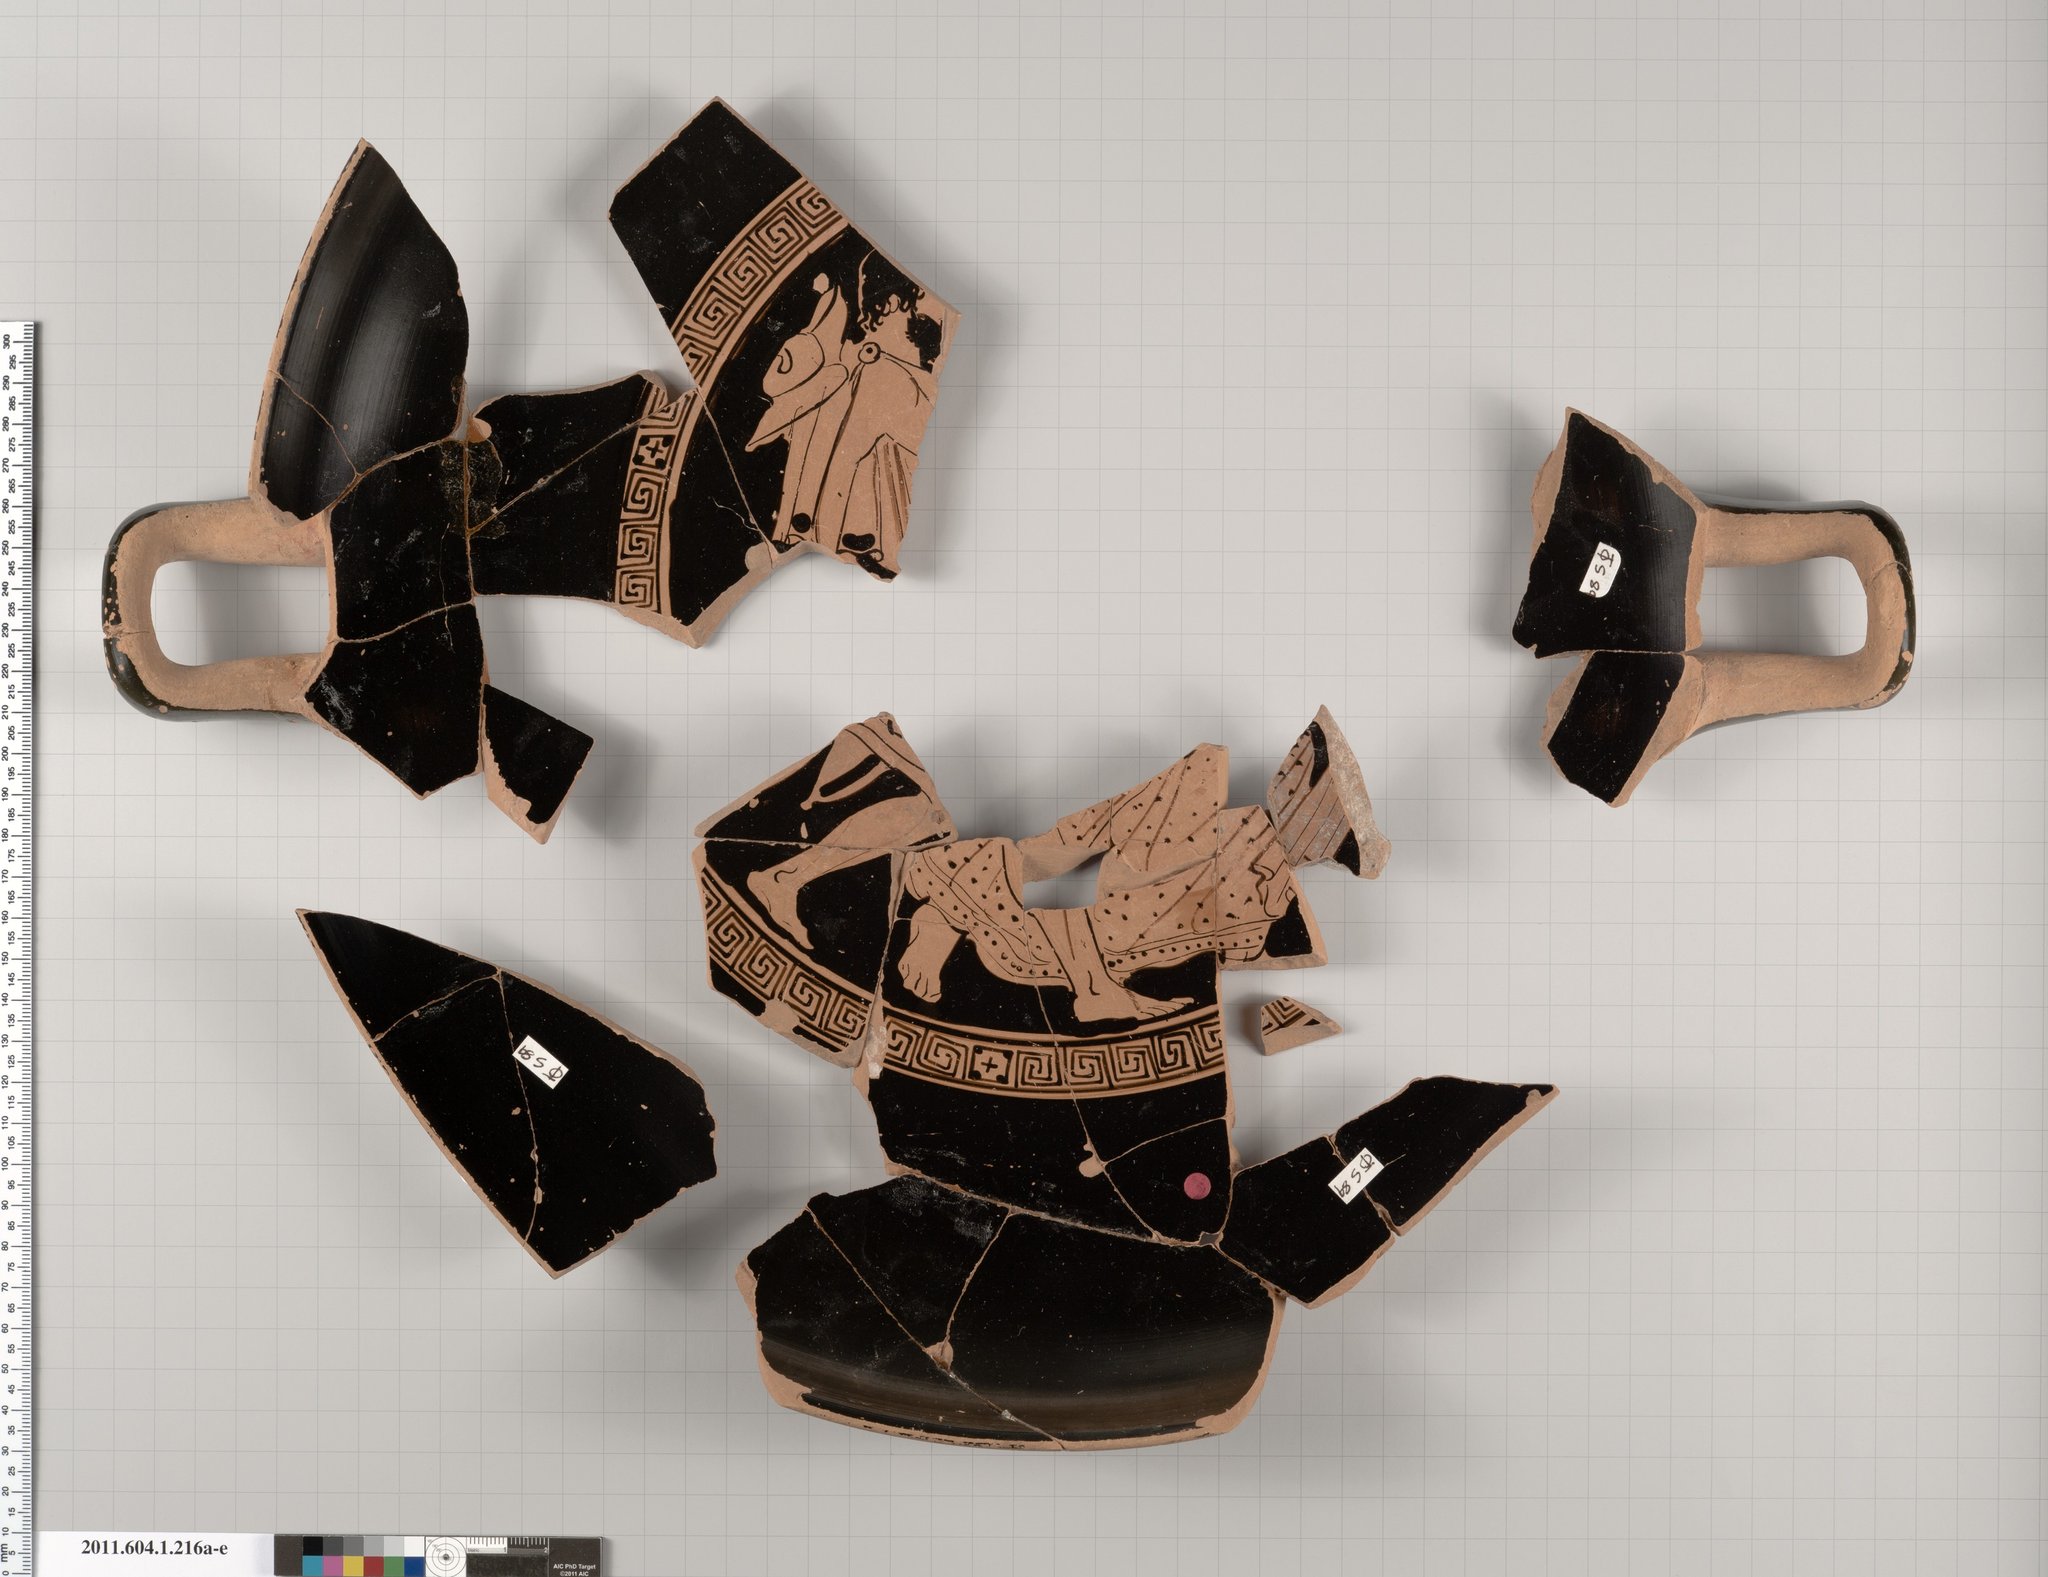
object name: kylix fragment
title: Terracotta fragments of a kylix (drinking cup)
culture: greek, attic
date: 467-435 BCE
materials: terracotta